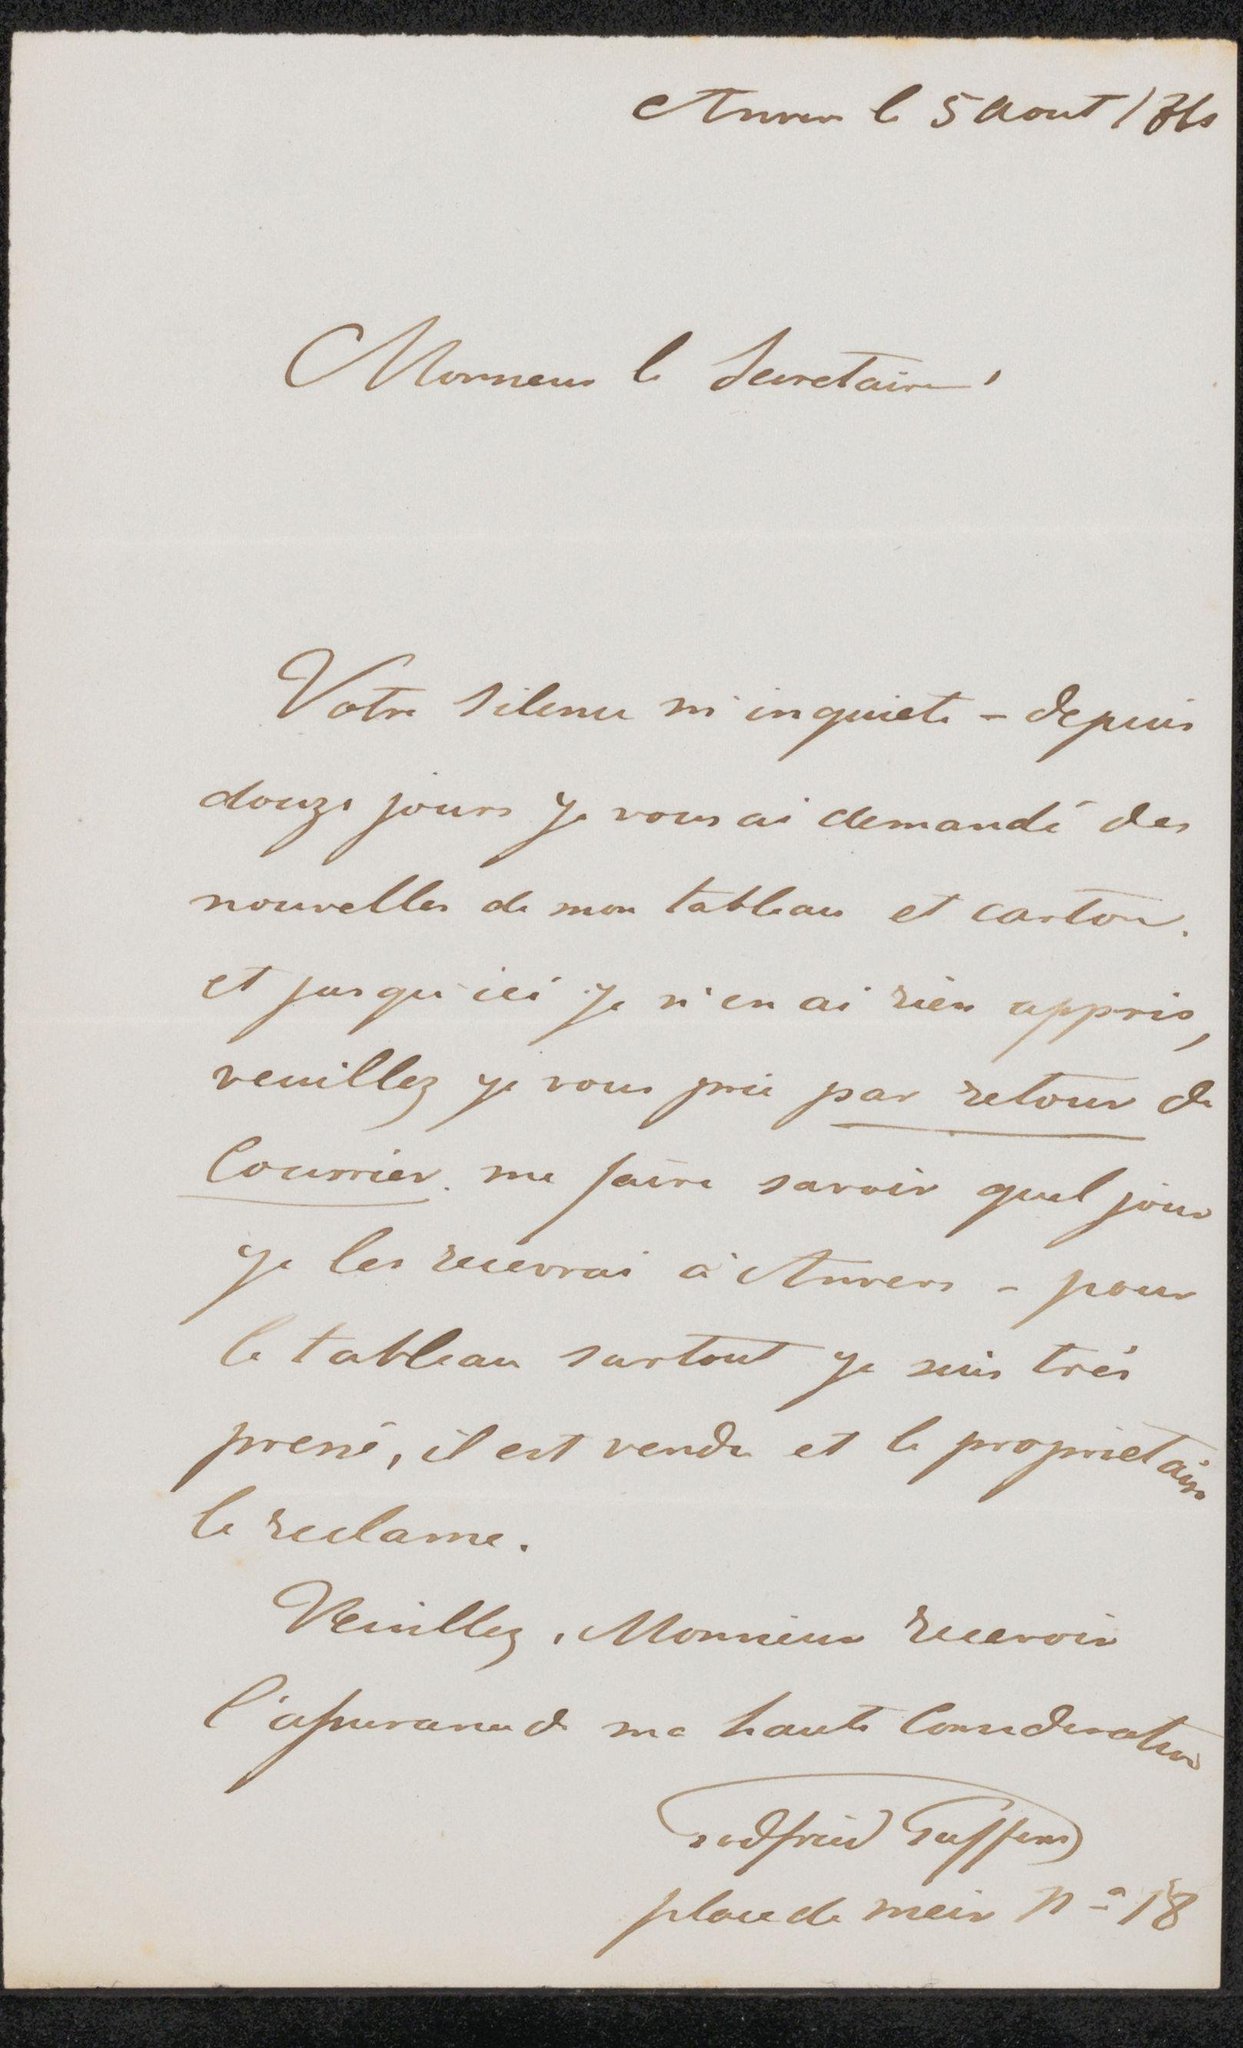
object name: letter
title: Brief aan anoniem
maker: godfried guffens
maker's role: painter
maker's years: 1823-1901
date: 1860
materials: ink, paper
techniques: pen, writing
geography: antwerp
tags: art trade, art shop, painting (including book-illumination, miniature-painting)